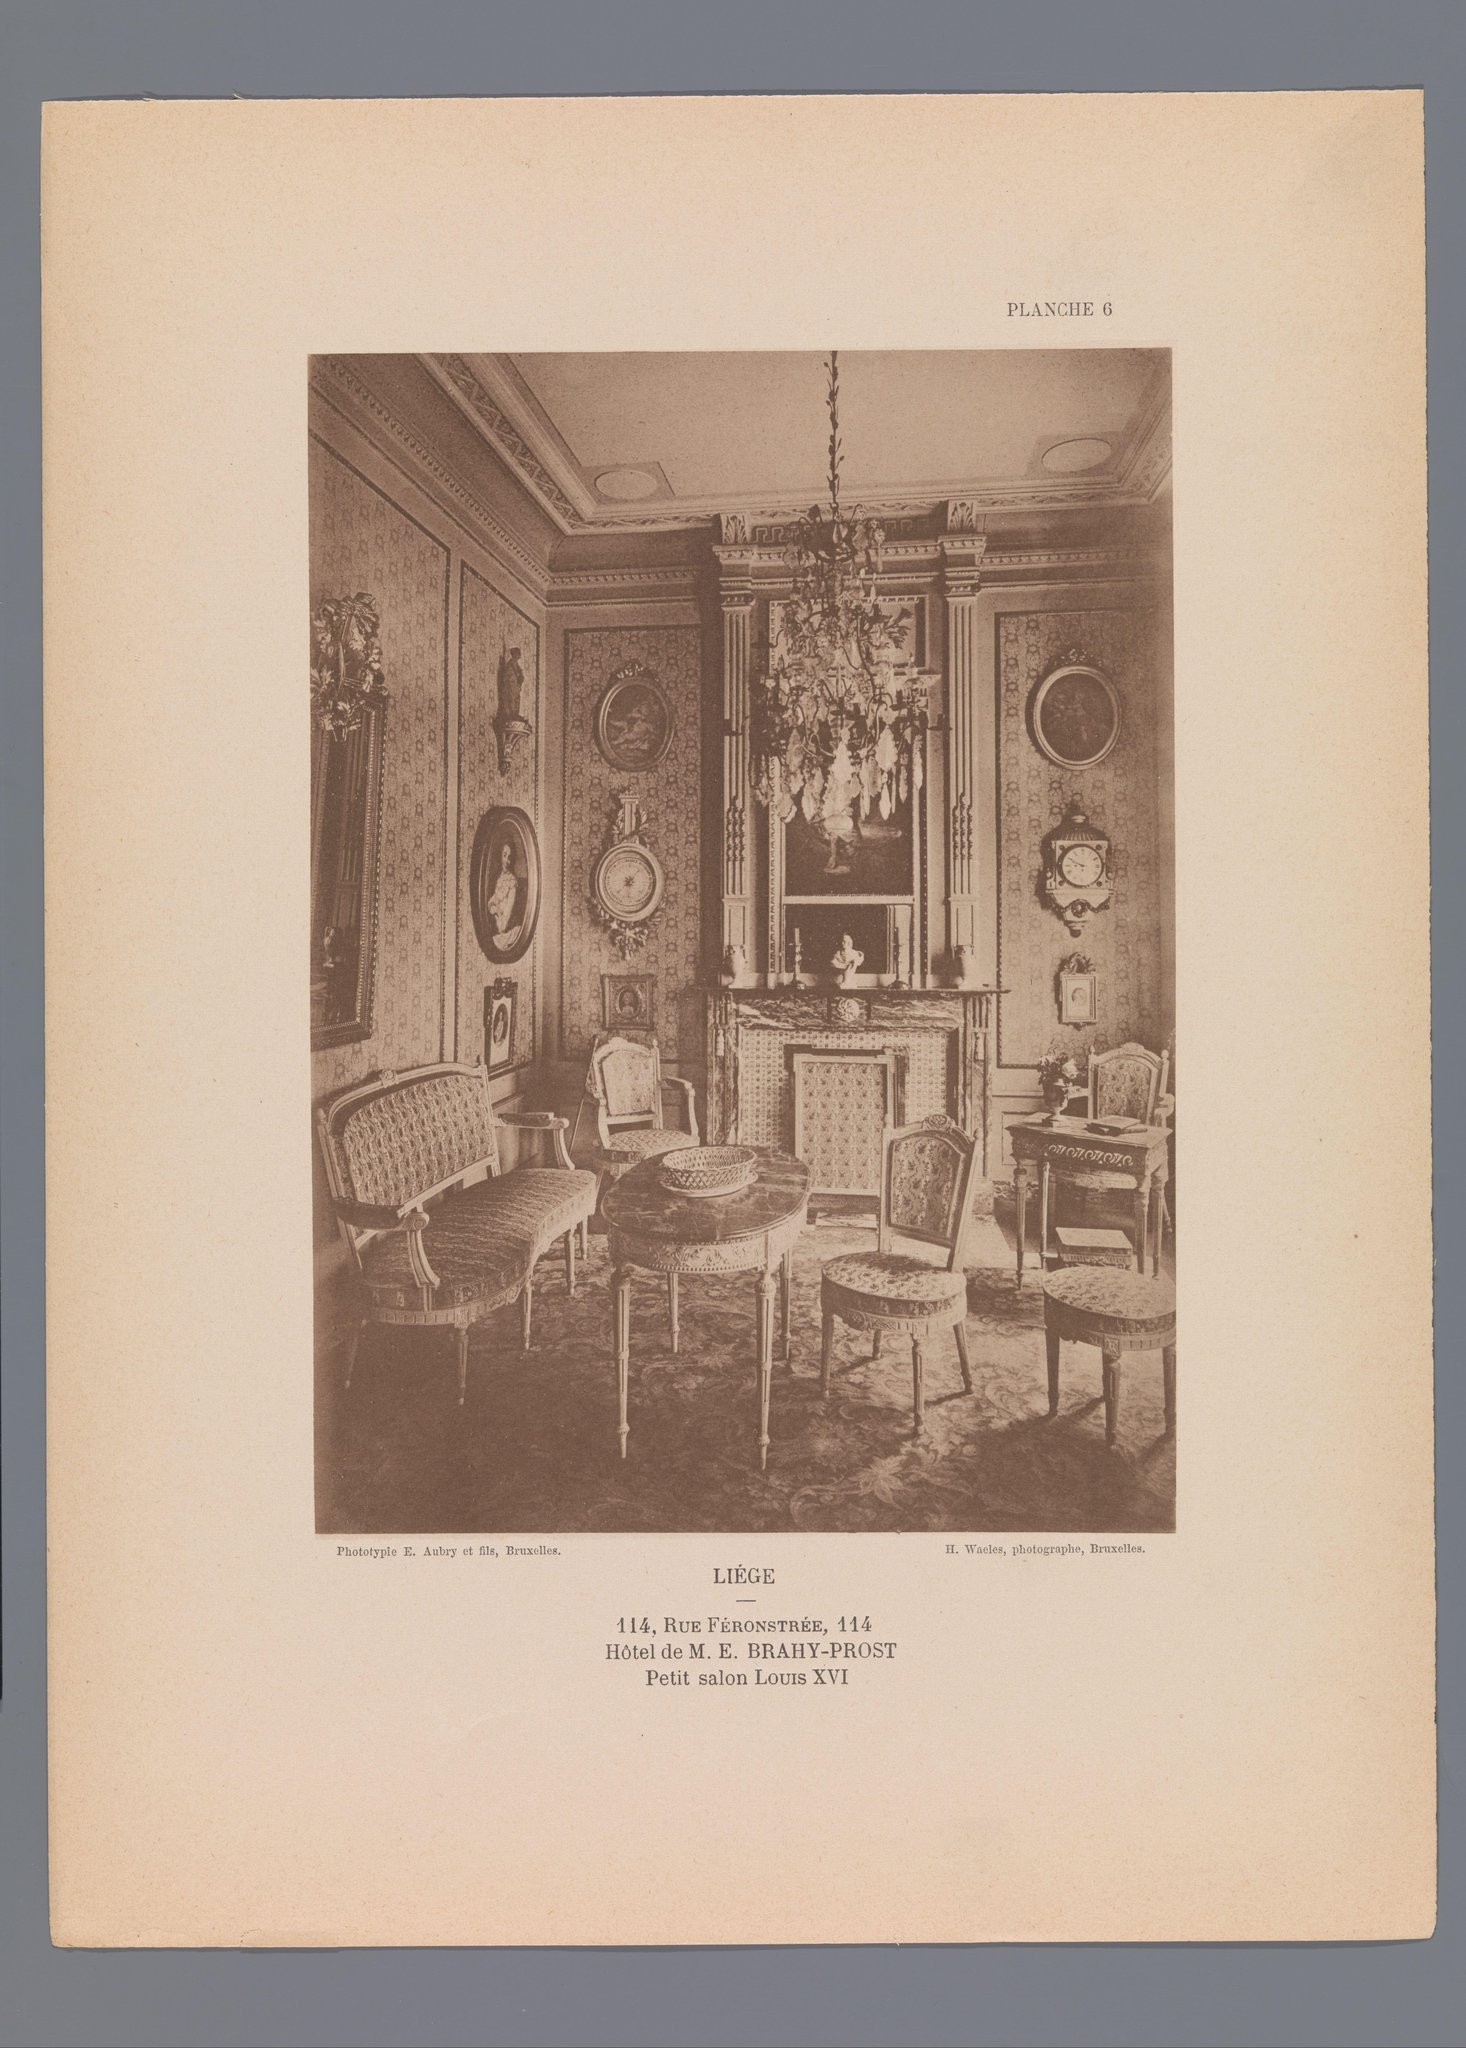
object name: photomechanical print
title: Liège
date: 1893-1898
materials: paper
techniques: photograph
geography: liège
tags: hotel room, interior of the house, liège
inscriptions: inscription: ‘114, Rue Féronstrée, 114/ Hôtel de M. E. BRAHY-PROST/ petit salon Louis XVI’, number: ‘PLANCHE 6’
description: Deze prent maakt deel uit van een omslag met 89 prenten en 5 tekstbladen.